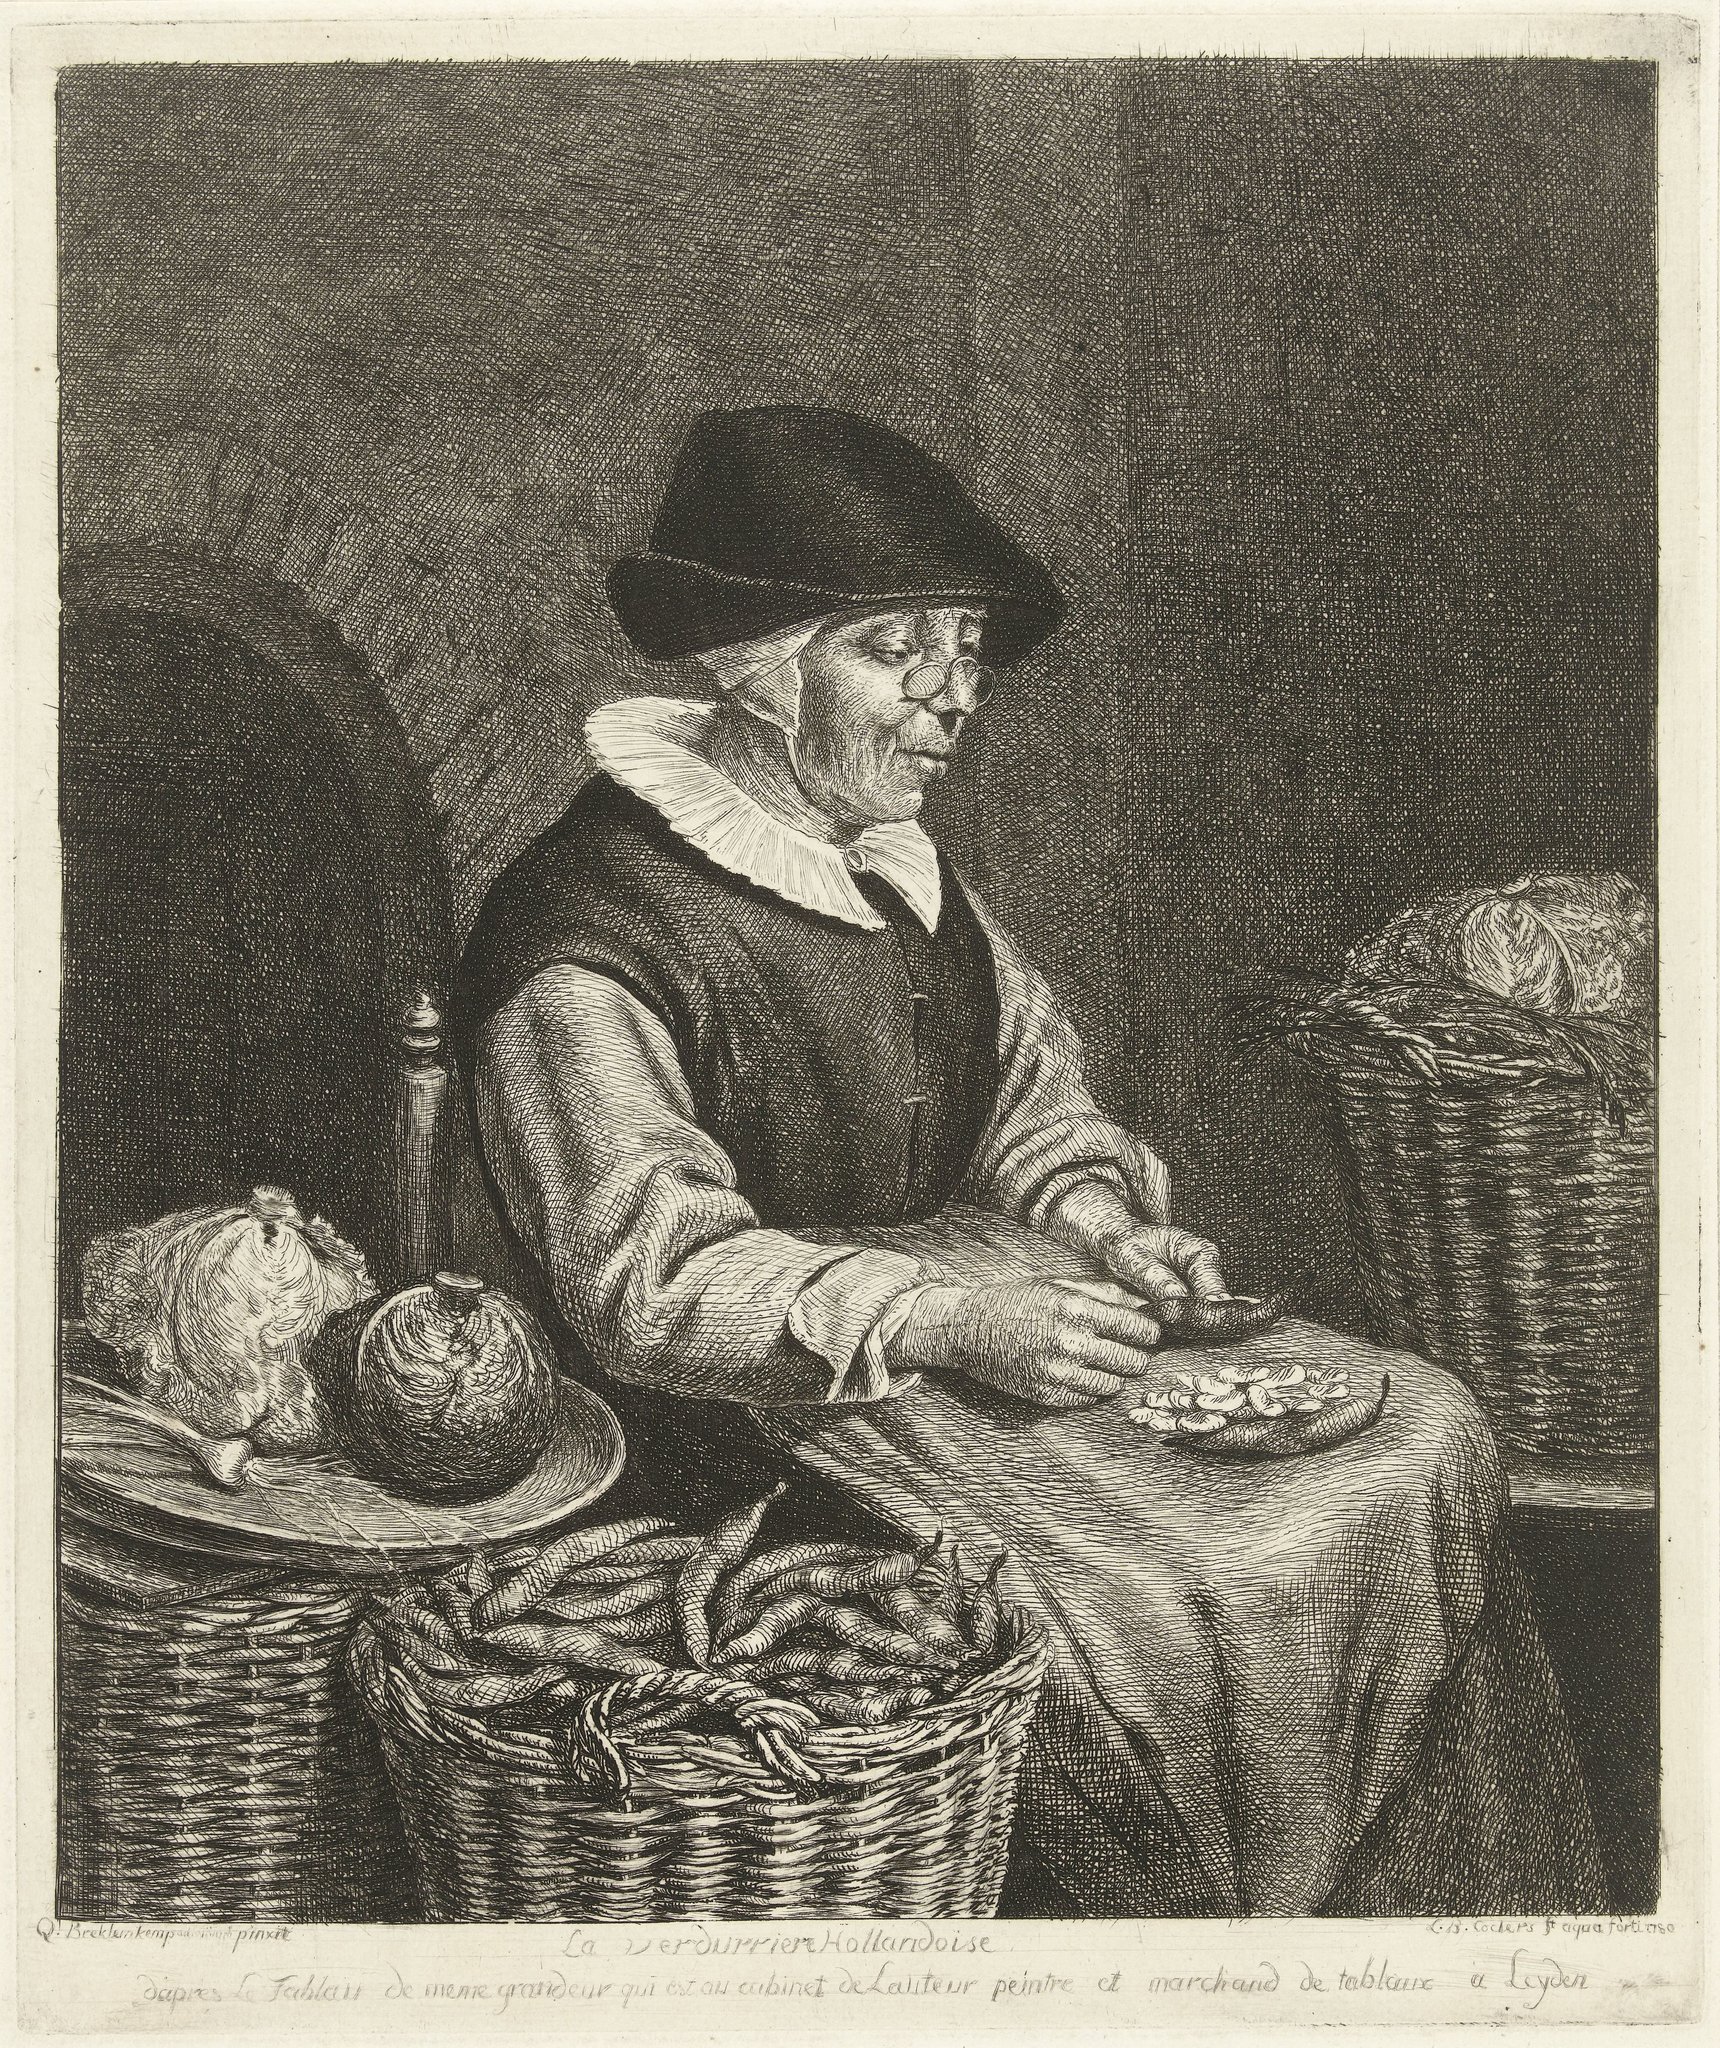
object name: print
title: Oude vrouw bij het boontjes doppen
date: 1780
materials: paper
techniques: etching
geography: leiden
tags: eyeglasses, spectacles, cleaning vegetables, cleaning fruit, e.g. peeling, fruits: beans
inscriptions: collector's mark: Lugt 2228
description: Een oude vrouw zit in de keuken op een stoel en dopt bonen. De boontjes doet ze in haar schort. Naast haar staan manden met kolen, lof en bonen. De vrouw draagt een donkere hoed en een knijpbril.